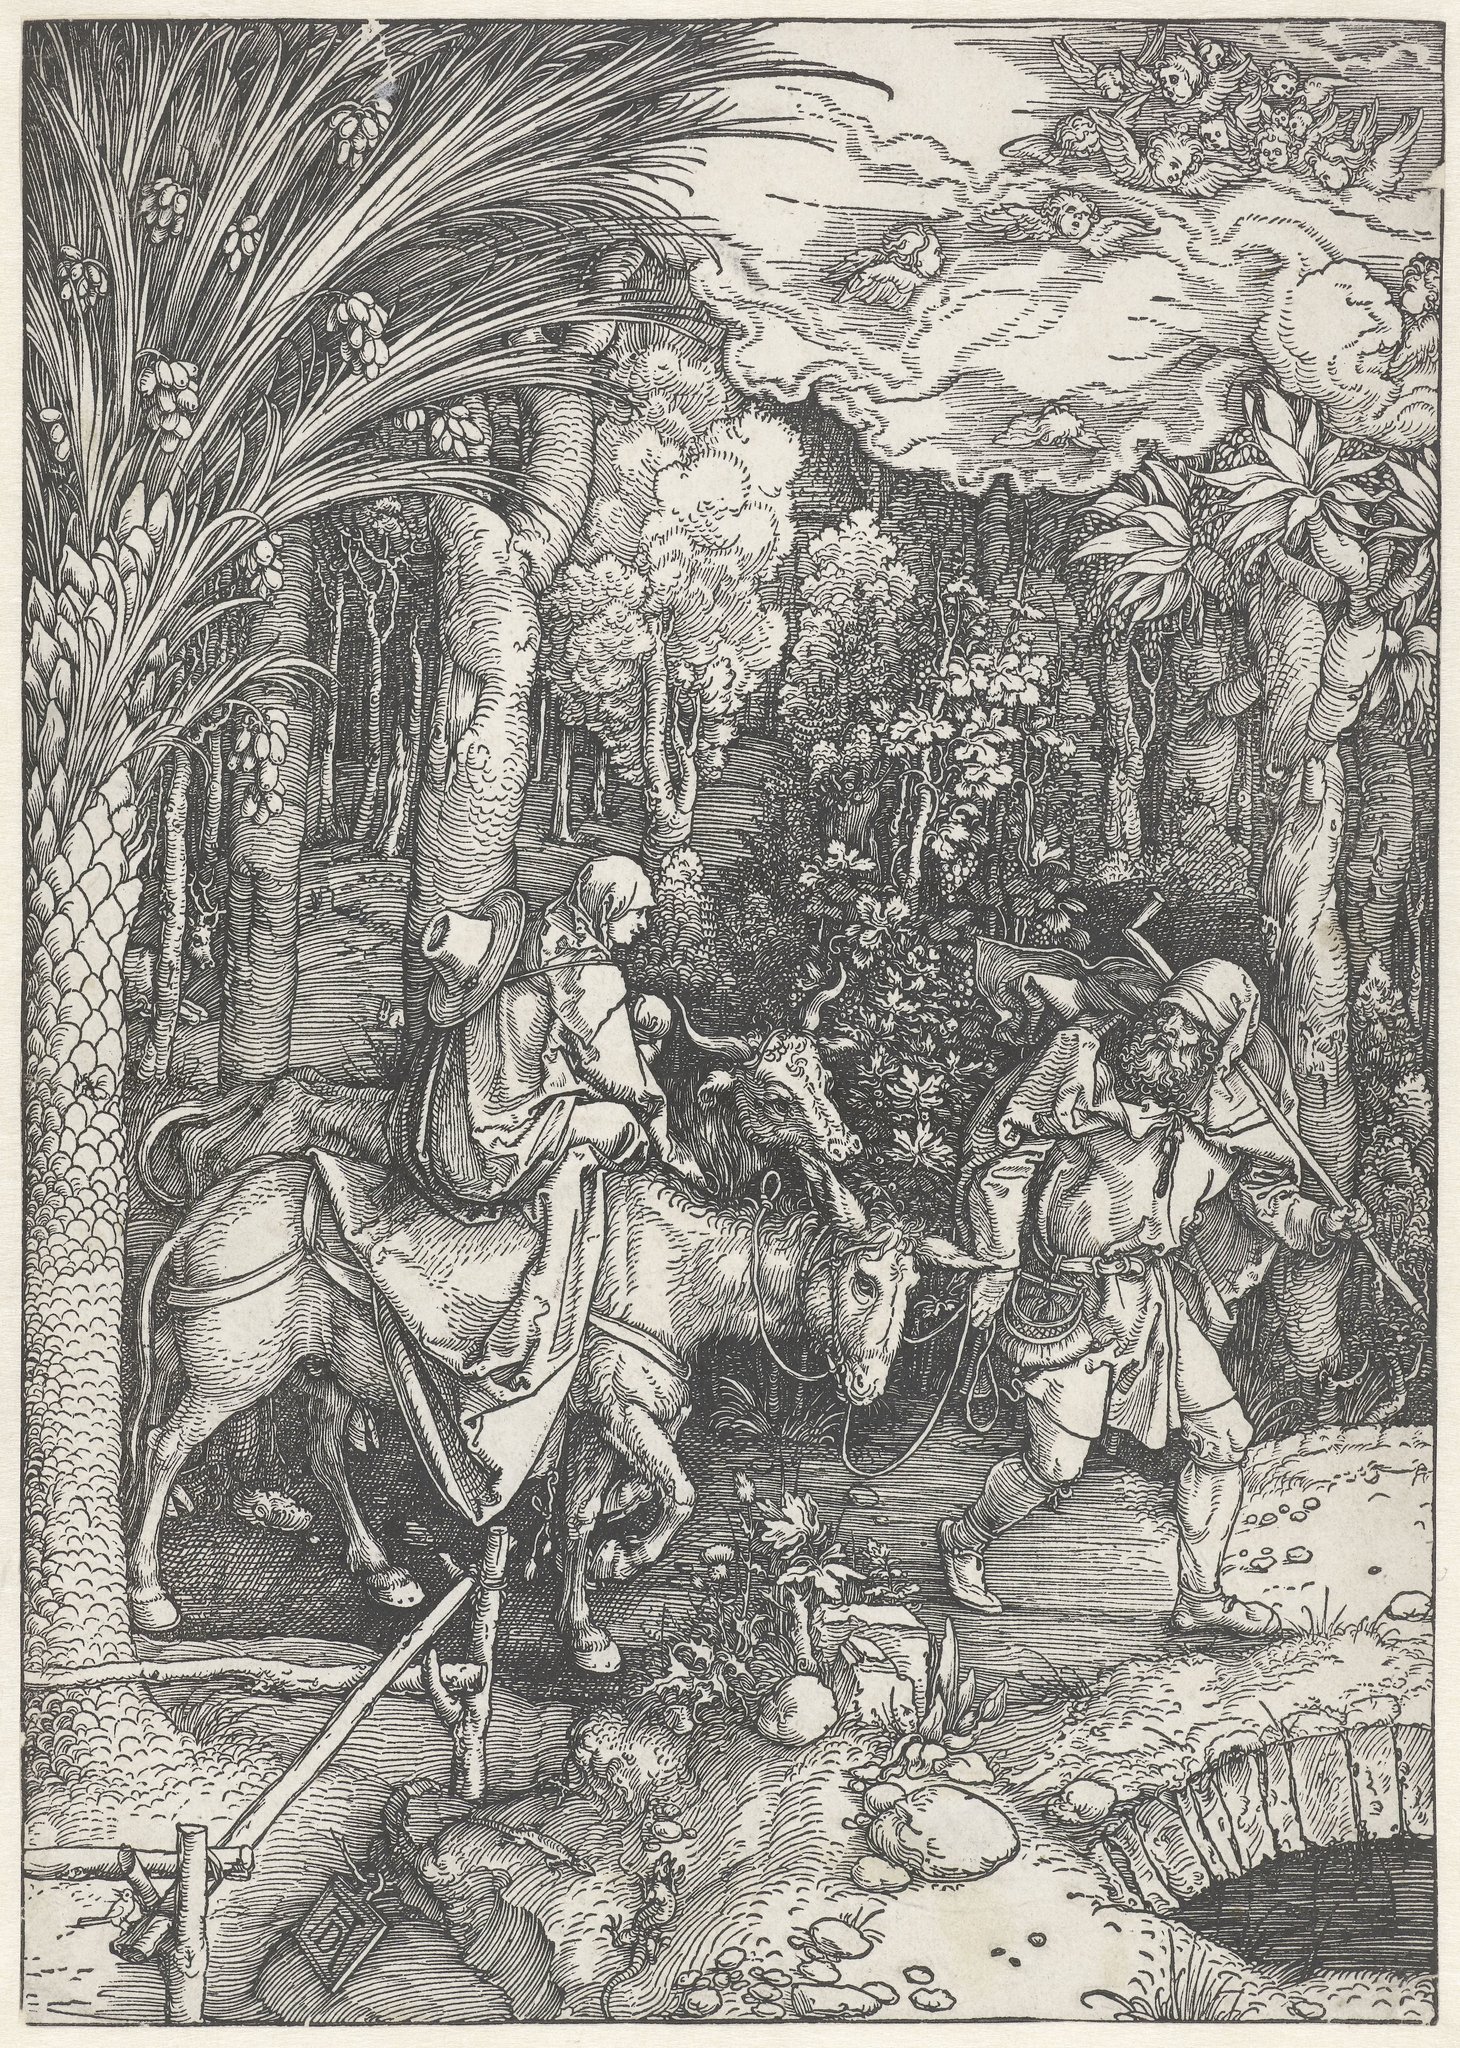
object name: print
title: Leven van Maria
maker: albrecht dürer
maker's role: draughtsman, painter, print maker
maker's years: 1471-1528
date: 1502-1506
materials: paper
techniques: woodcut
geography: nuremberg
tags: the flight into egypt: mary, joseph, the child (and sometimes others) on their way; mary usually riding on an ass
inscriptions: collector's mark: Lugt 240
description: Jozef voert een ezeltje, waarop Maria met het Christuskind zit, en een rund mee door een bos. Deze prent is onderdeel van een serie van 20 prenten, bestaand uit een titelprent en 19 prenten met scènes uit het leven van Maria.